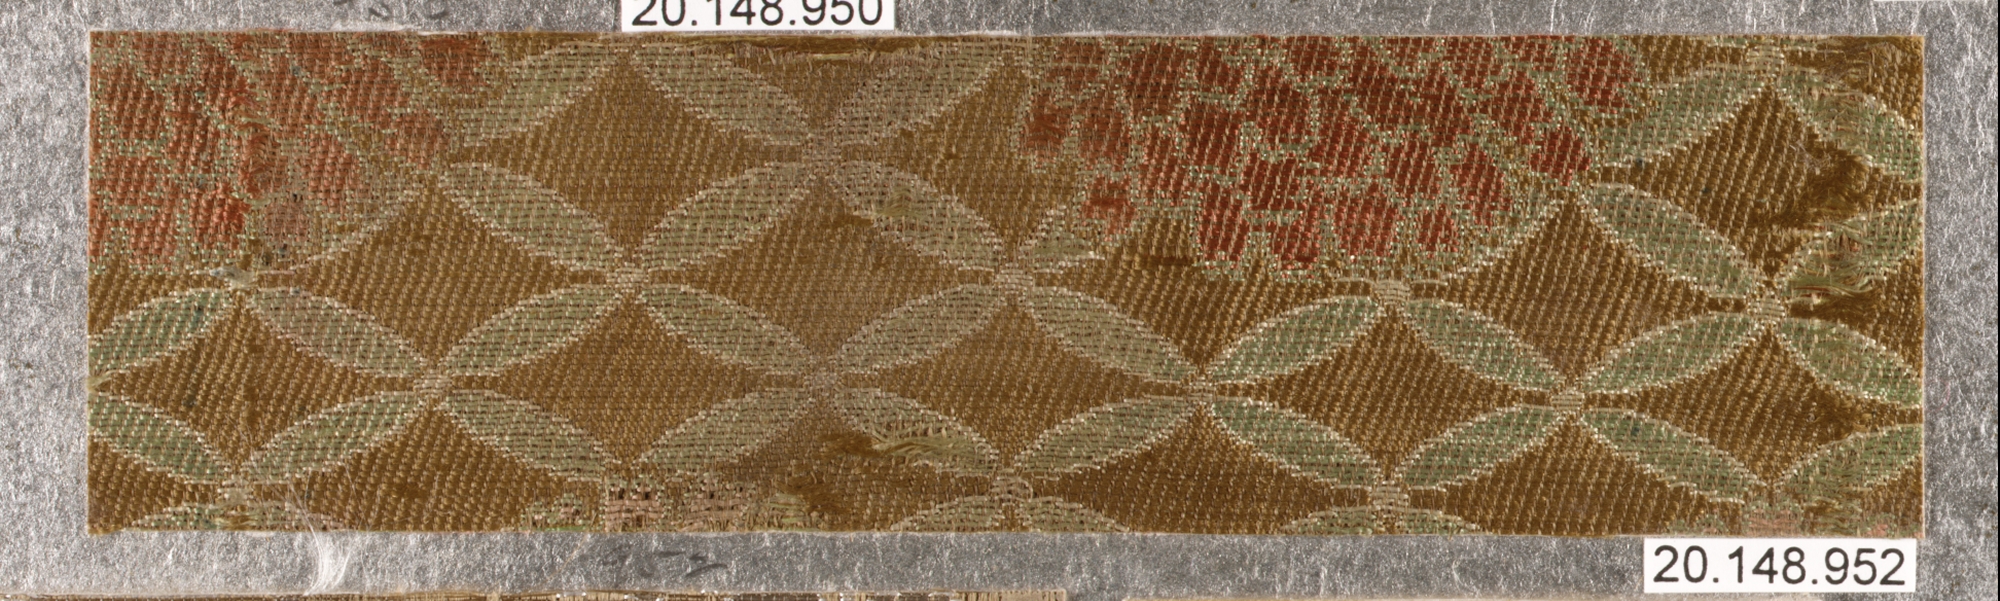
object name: piece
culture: japanese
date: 1701-1800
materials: silk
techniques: compound weave